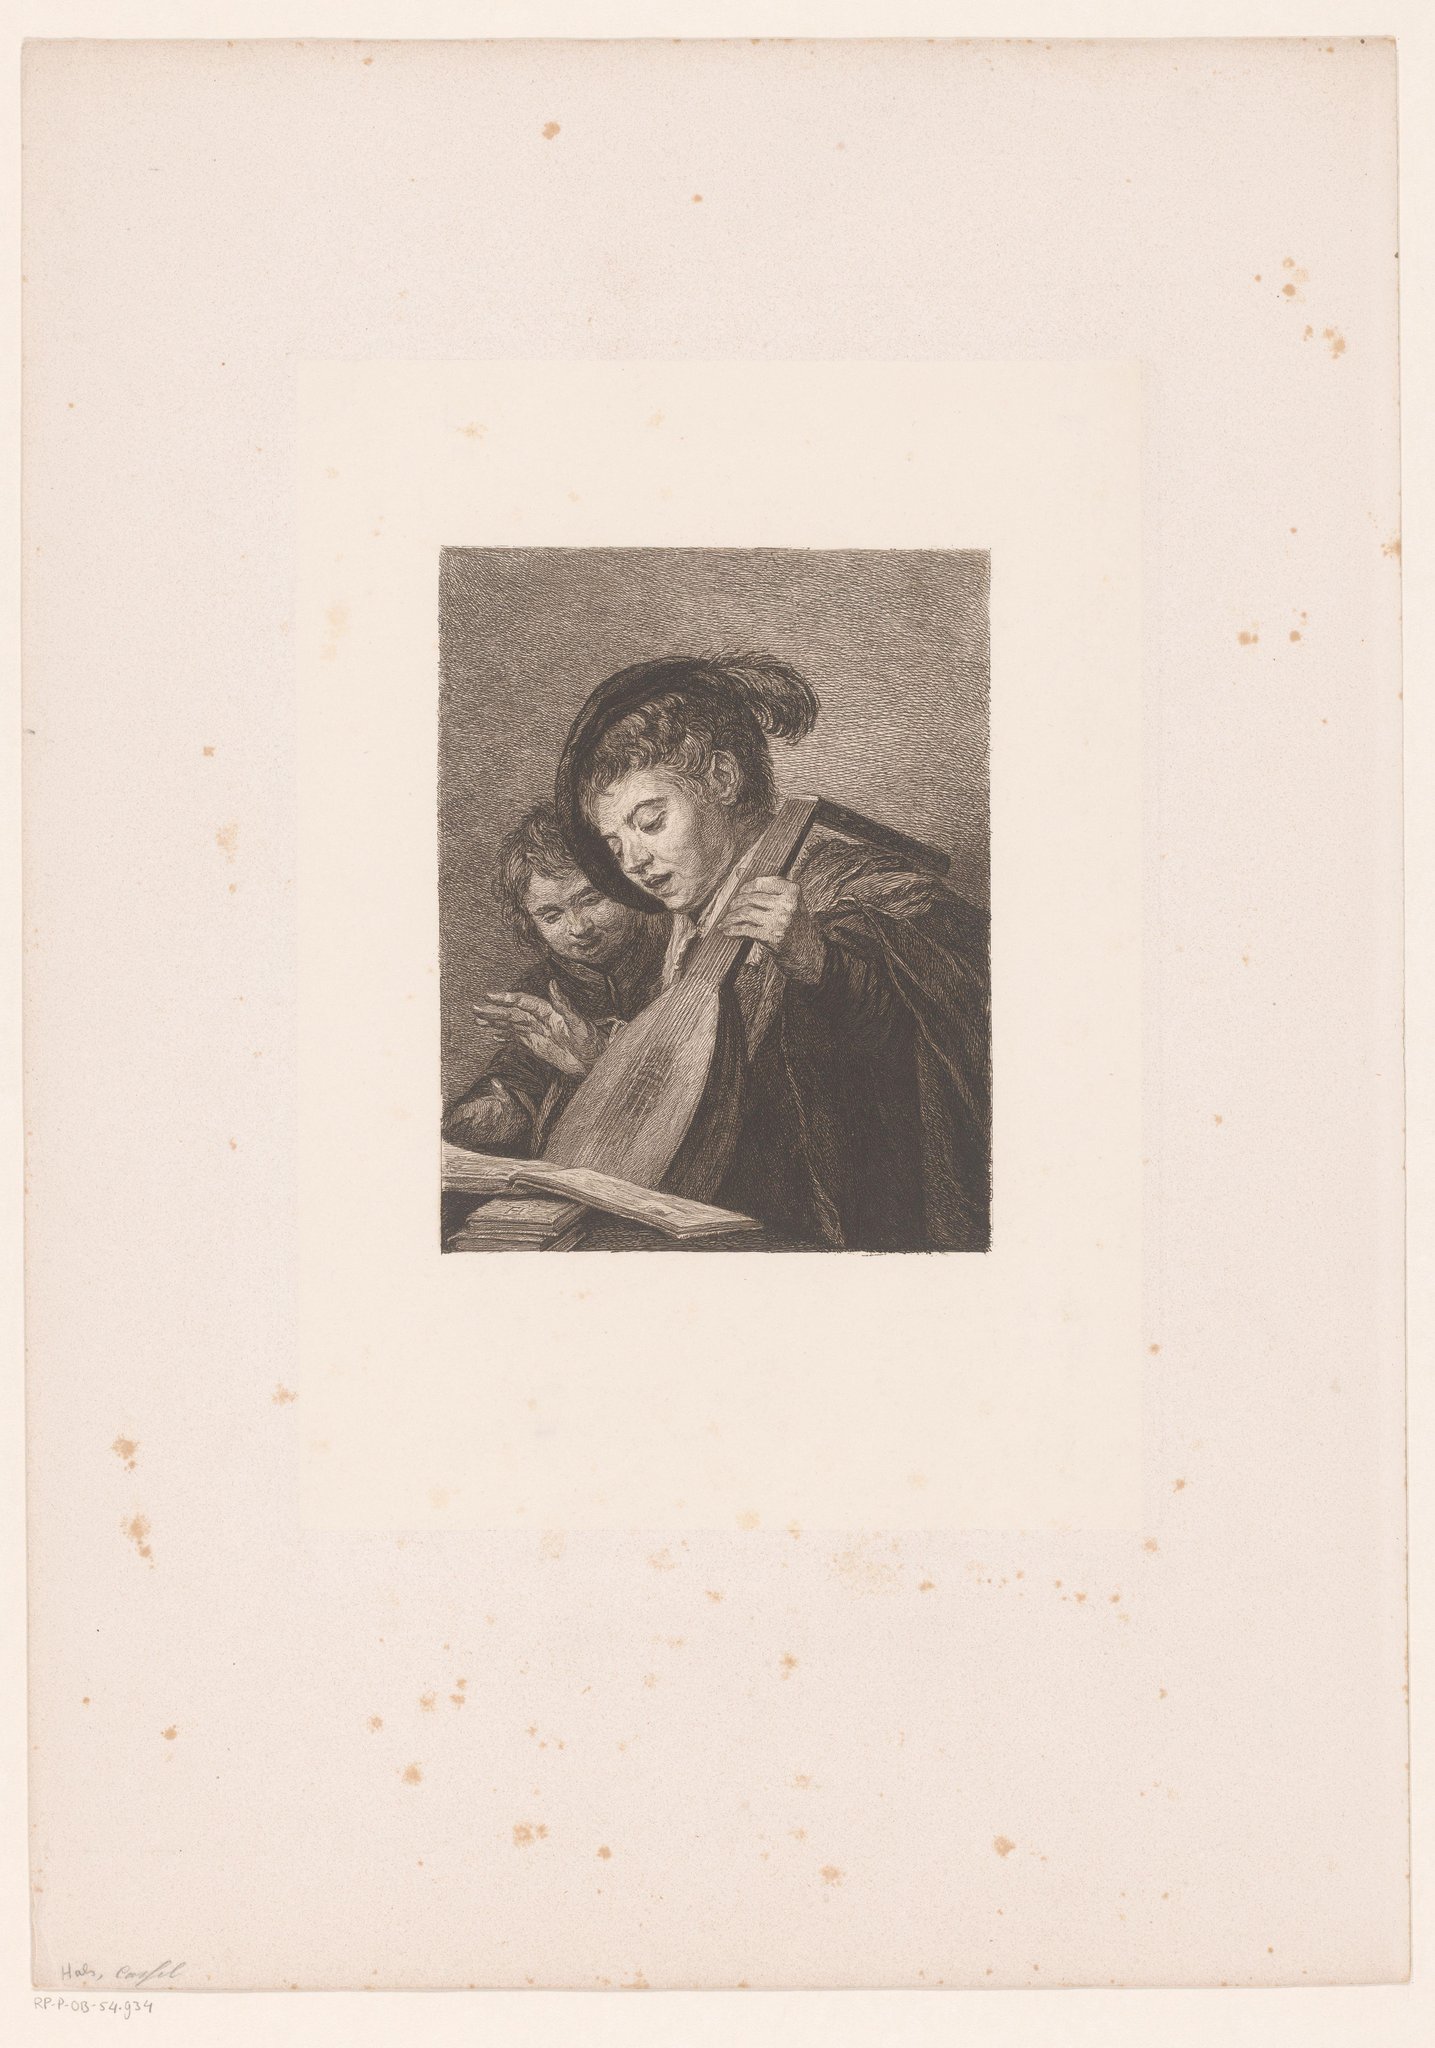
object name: print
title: Twee zingende jongens met een luit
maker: william unger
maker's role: draughtsman, painter, print maker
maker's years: 1837-1932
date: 1847-1889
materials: paper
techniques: etching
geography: germany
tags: one person playing string instrument (plucked), children singing, lute, and special forms of lute, e.g.: theorbo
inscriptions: collector's mark: Lugt 2228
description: Prent naar het schilderij door Frans Hals in de Gemäldegalerie Alte Meister te Kassel (inv.nr. GK 215).